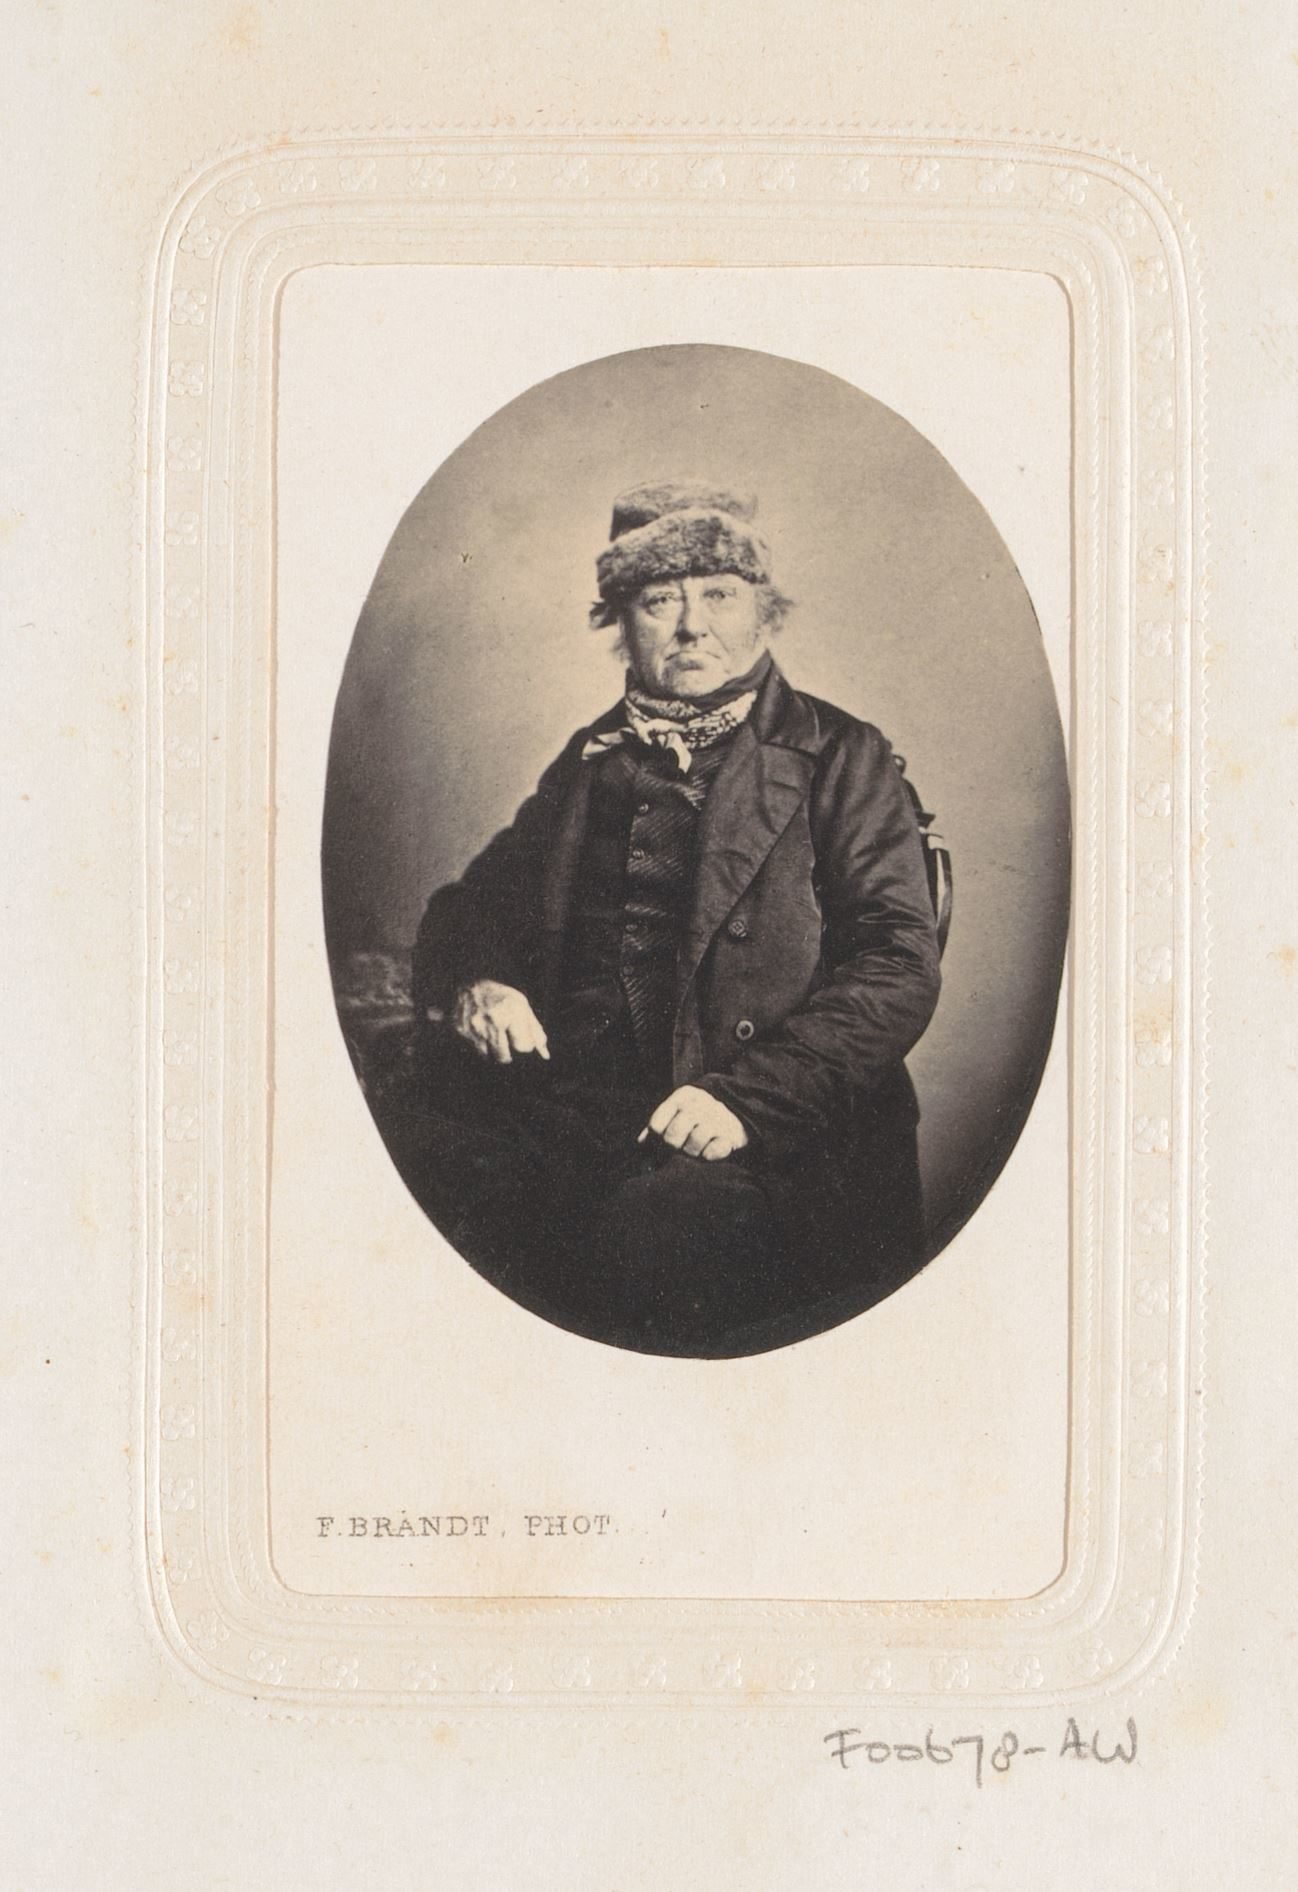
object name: photograph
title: Portret van een zittende man met bontmuts en sjaal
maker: friedrich brandt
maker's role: fotograaf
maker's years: 1823-1891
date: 1860-1880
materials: cardboard, photographic support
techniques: albumen print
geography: flensburg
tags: head-gear (with name), historical persons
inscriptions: inscription: ‘F. Brandts/ photographisches atelier in Flensburg’